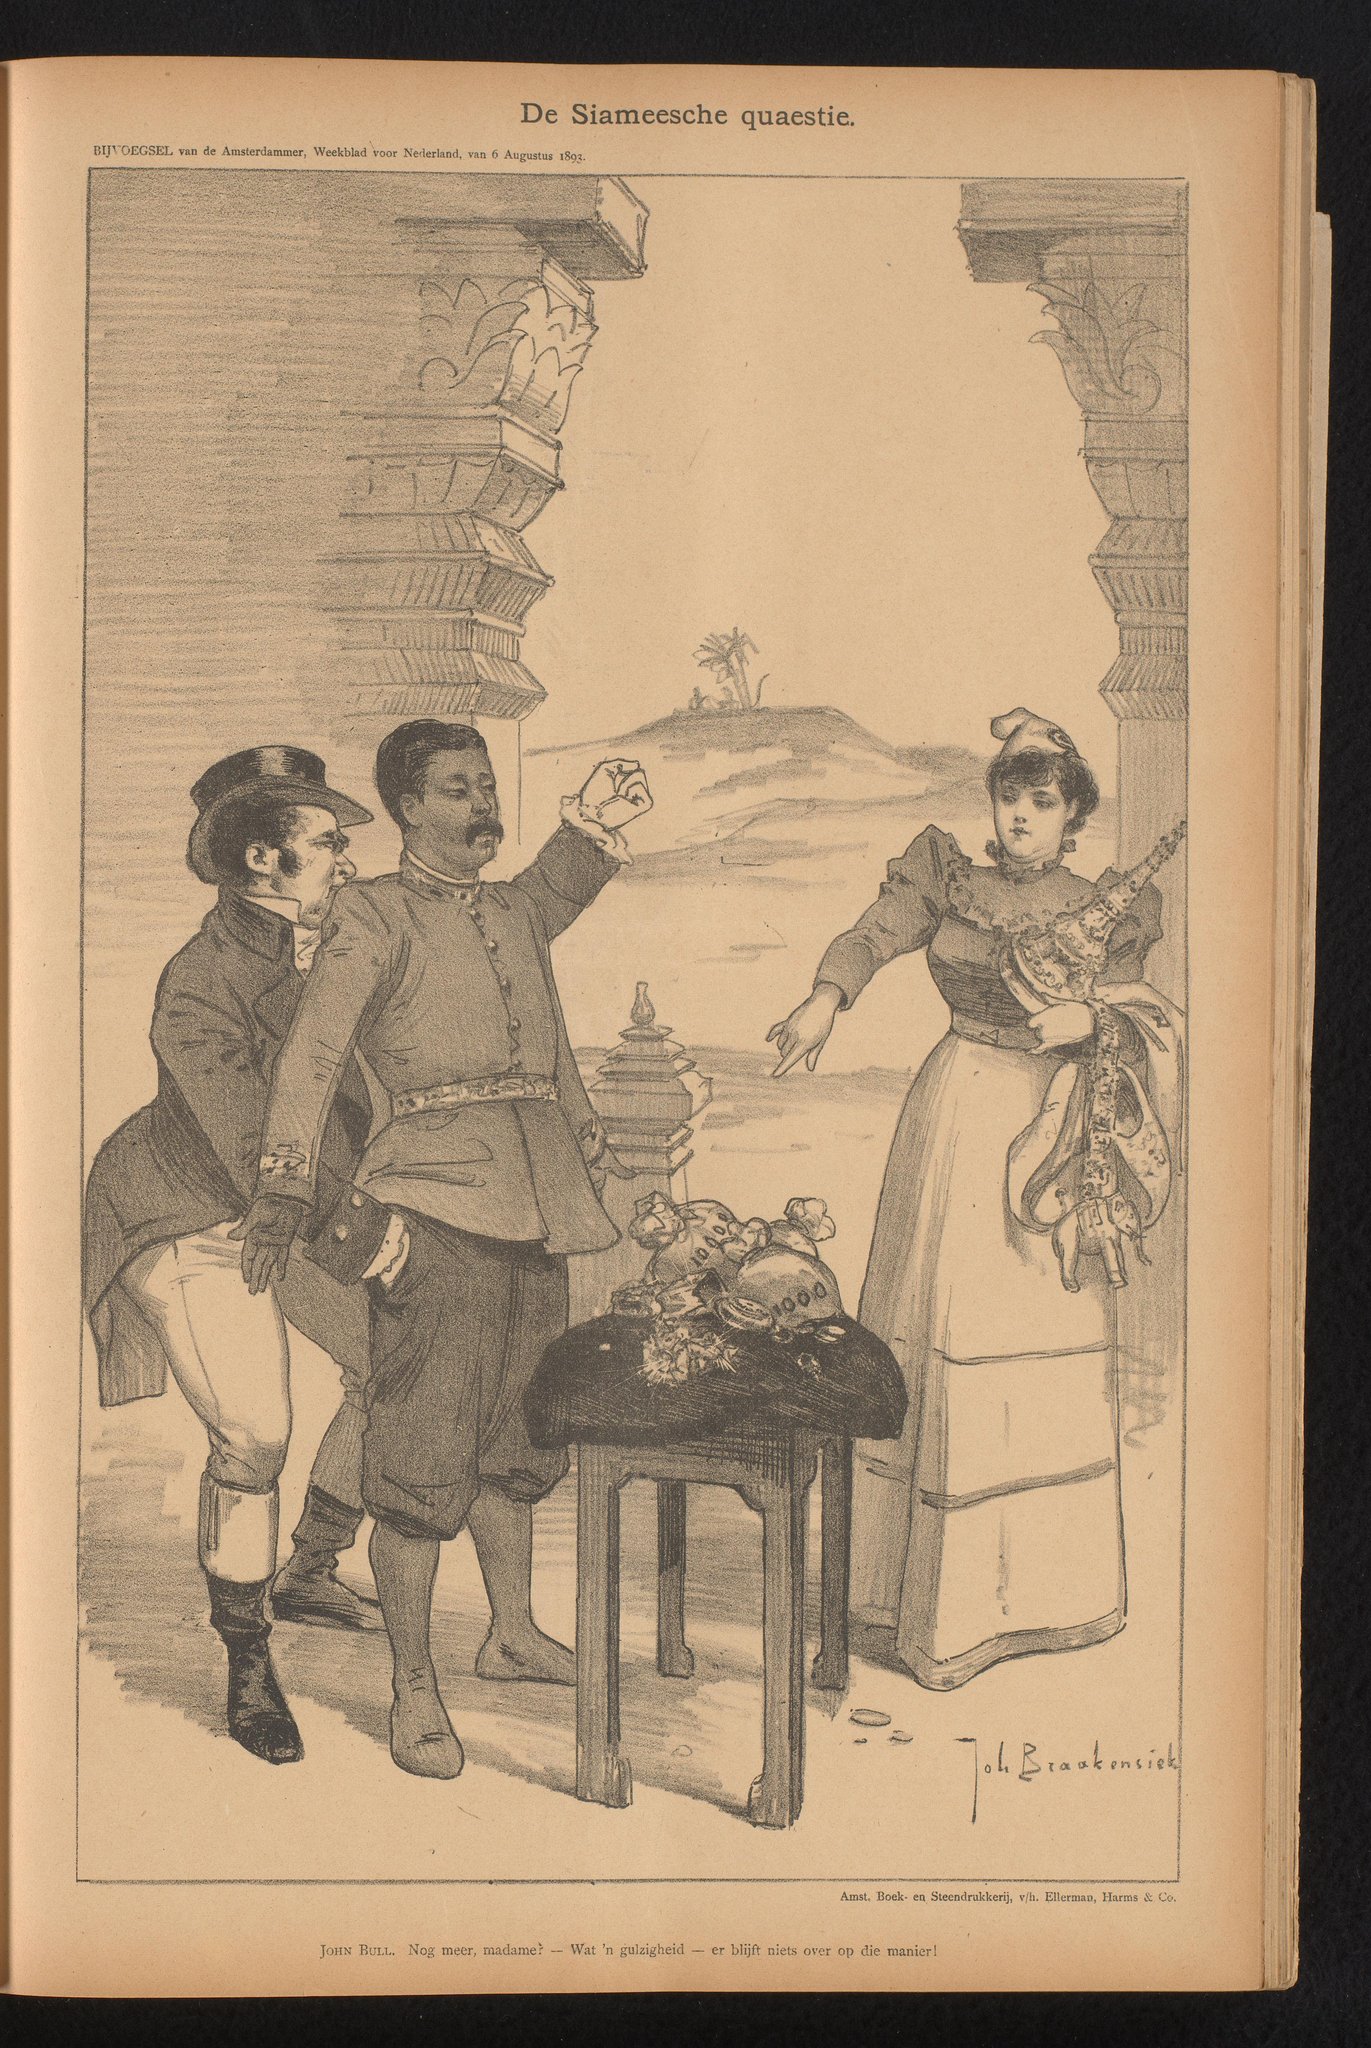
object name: cartoon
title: De Siameesche quaestie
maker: johan braakensiek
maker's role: draughtsman, print maker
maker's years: 1858-1940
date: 1893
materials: paper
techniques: lithograph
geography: netherlands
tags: imperialism, personifications of countries, nations, states, districts, etc., pickpocket, political caricatures and satires, thailand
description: Marianne (Frankrijk) met de armen vol van goederen gestolen van het koninkrijk Thailand (Siam). John Bull (Engeland) spreekt daar schande van terwijl hij zelf de zakken rolt van de koning van Thailand, Phra Chula Chomklao Chaoyuhua, beter bekend als koning Rama V of Chulalongkorn de Grote. Naar aanleiding van een militaire provocatie van de Fransen bij de grens met Indochina waarna Frankrijk gebieden in Thailand ten oosten van de rivier de Mekong opeiste.